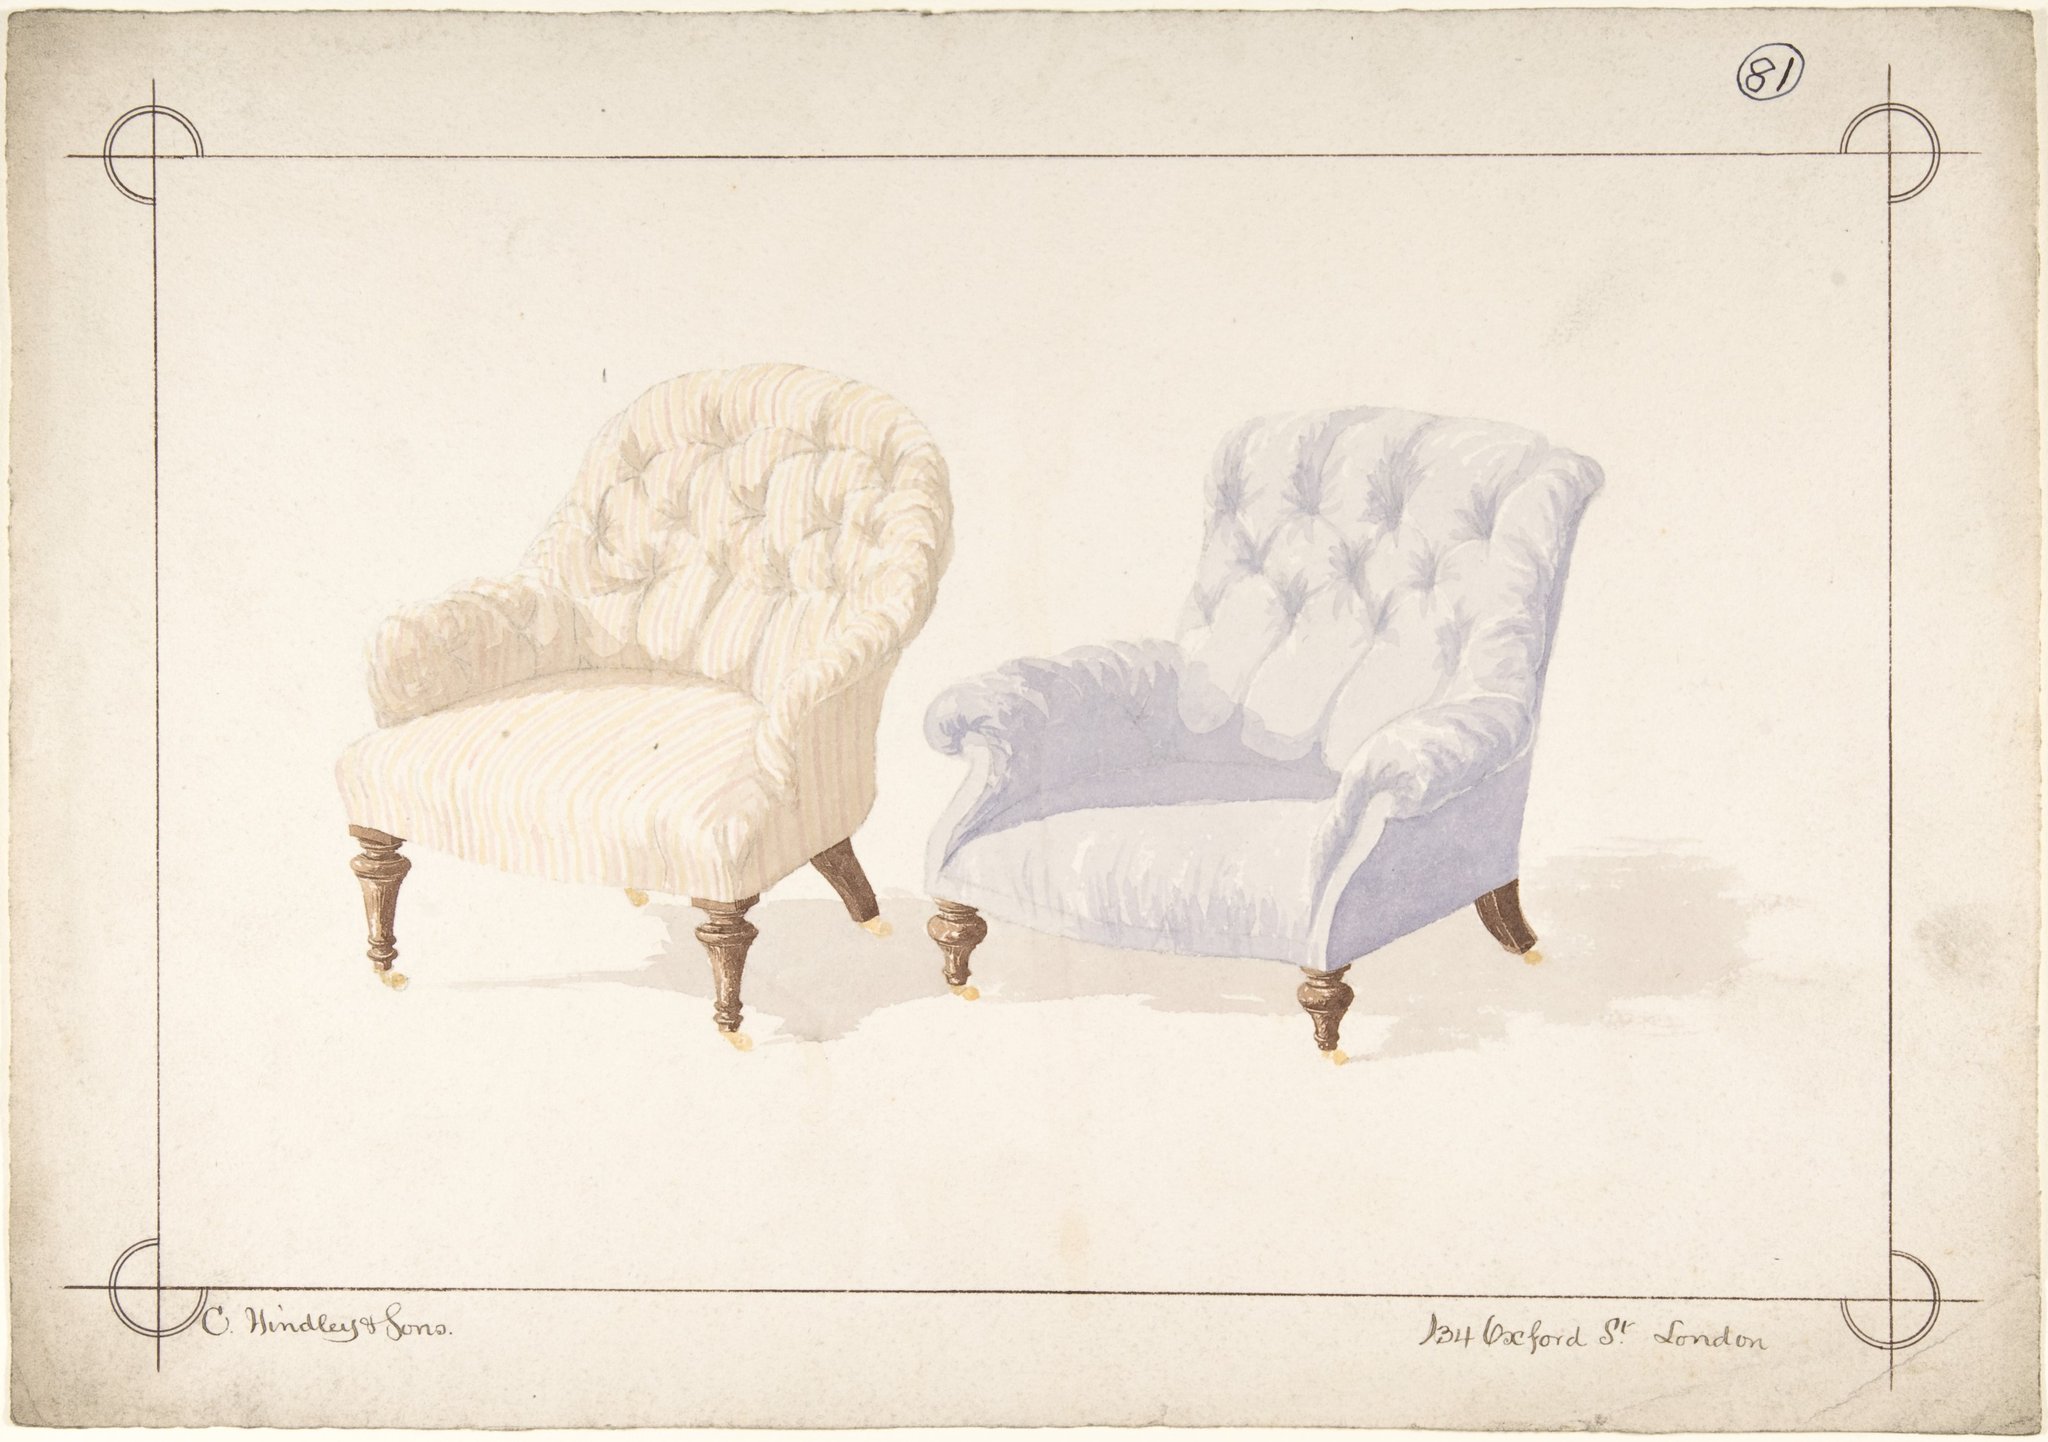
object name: drawing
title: Designs for Two Chairs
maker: charles hindley and sons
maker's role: artist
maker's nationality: british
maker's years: 1841-1917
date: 1841-1884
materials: graphite, watercolor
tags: chairs